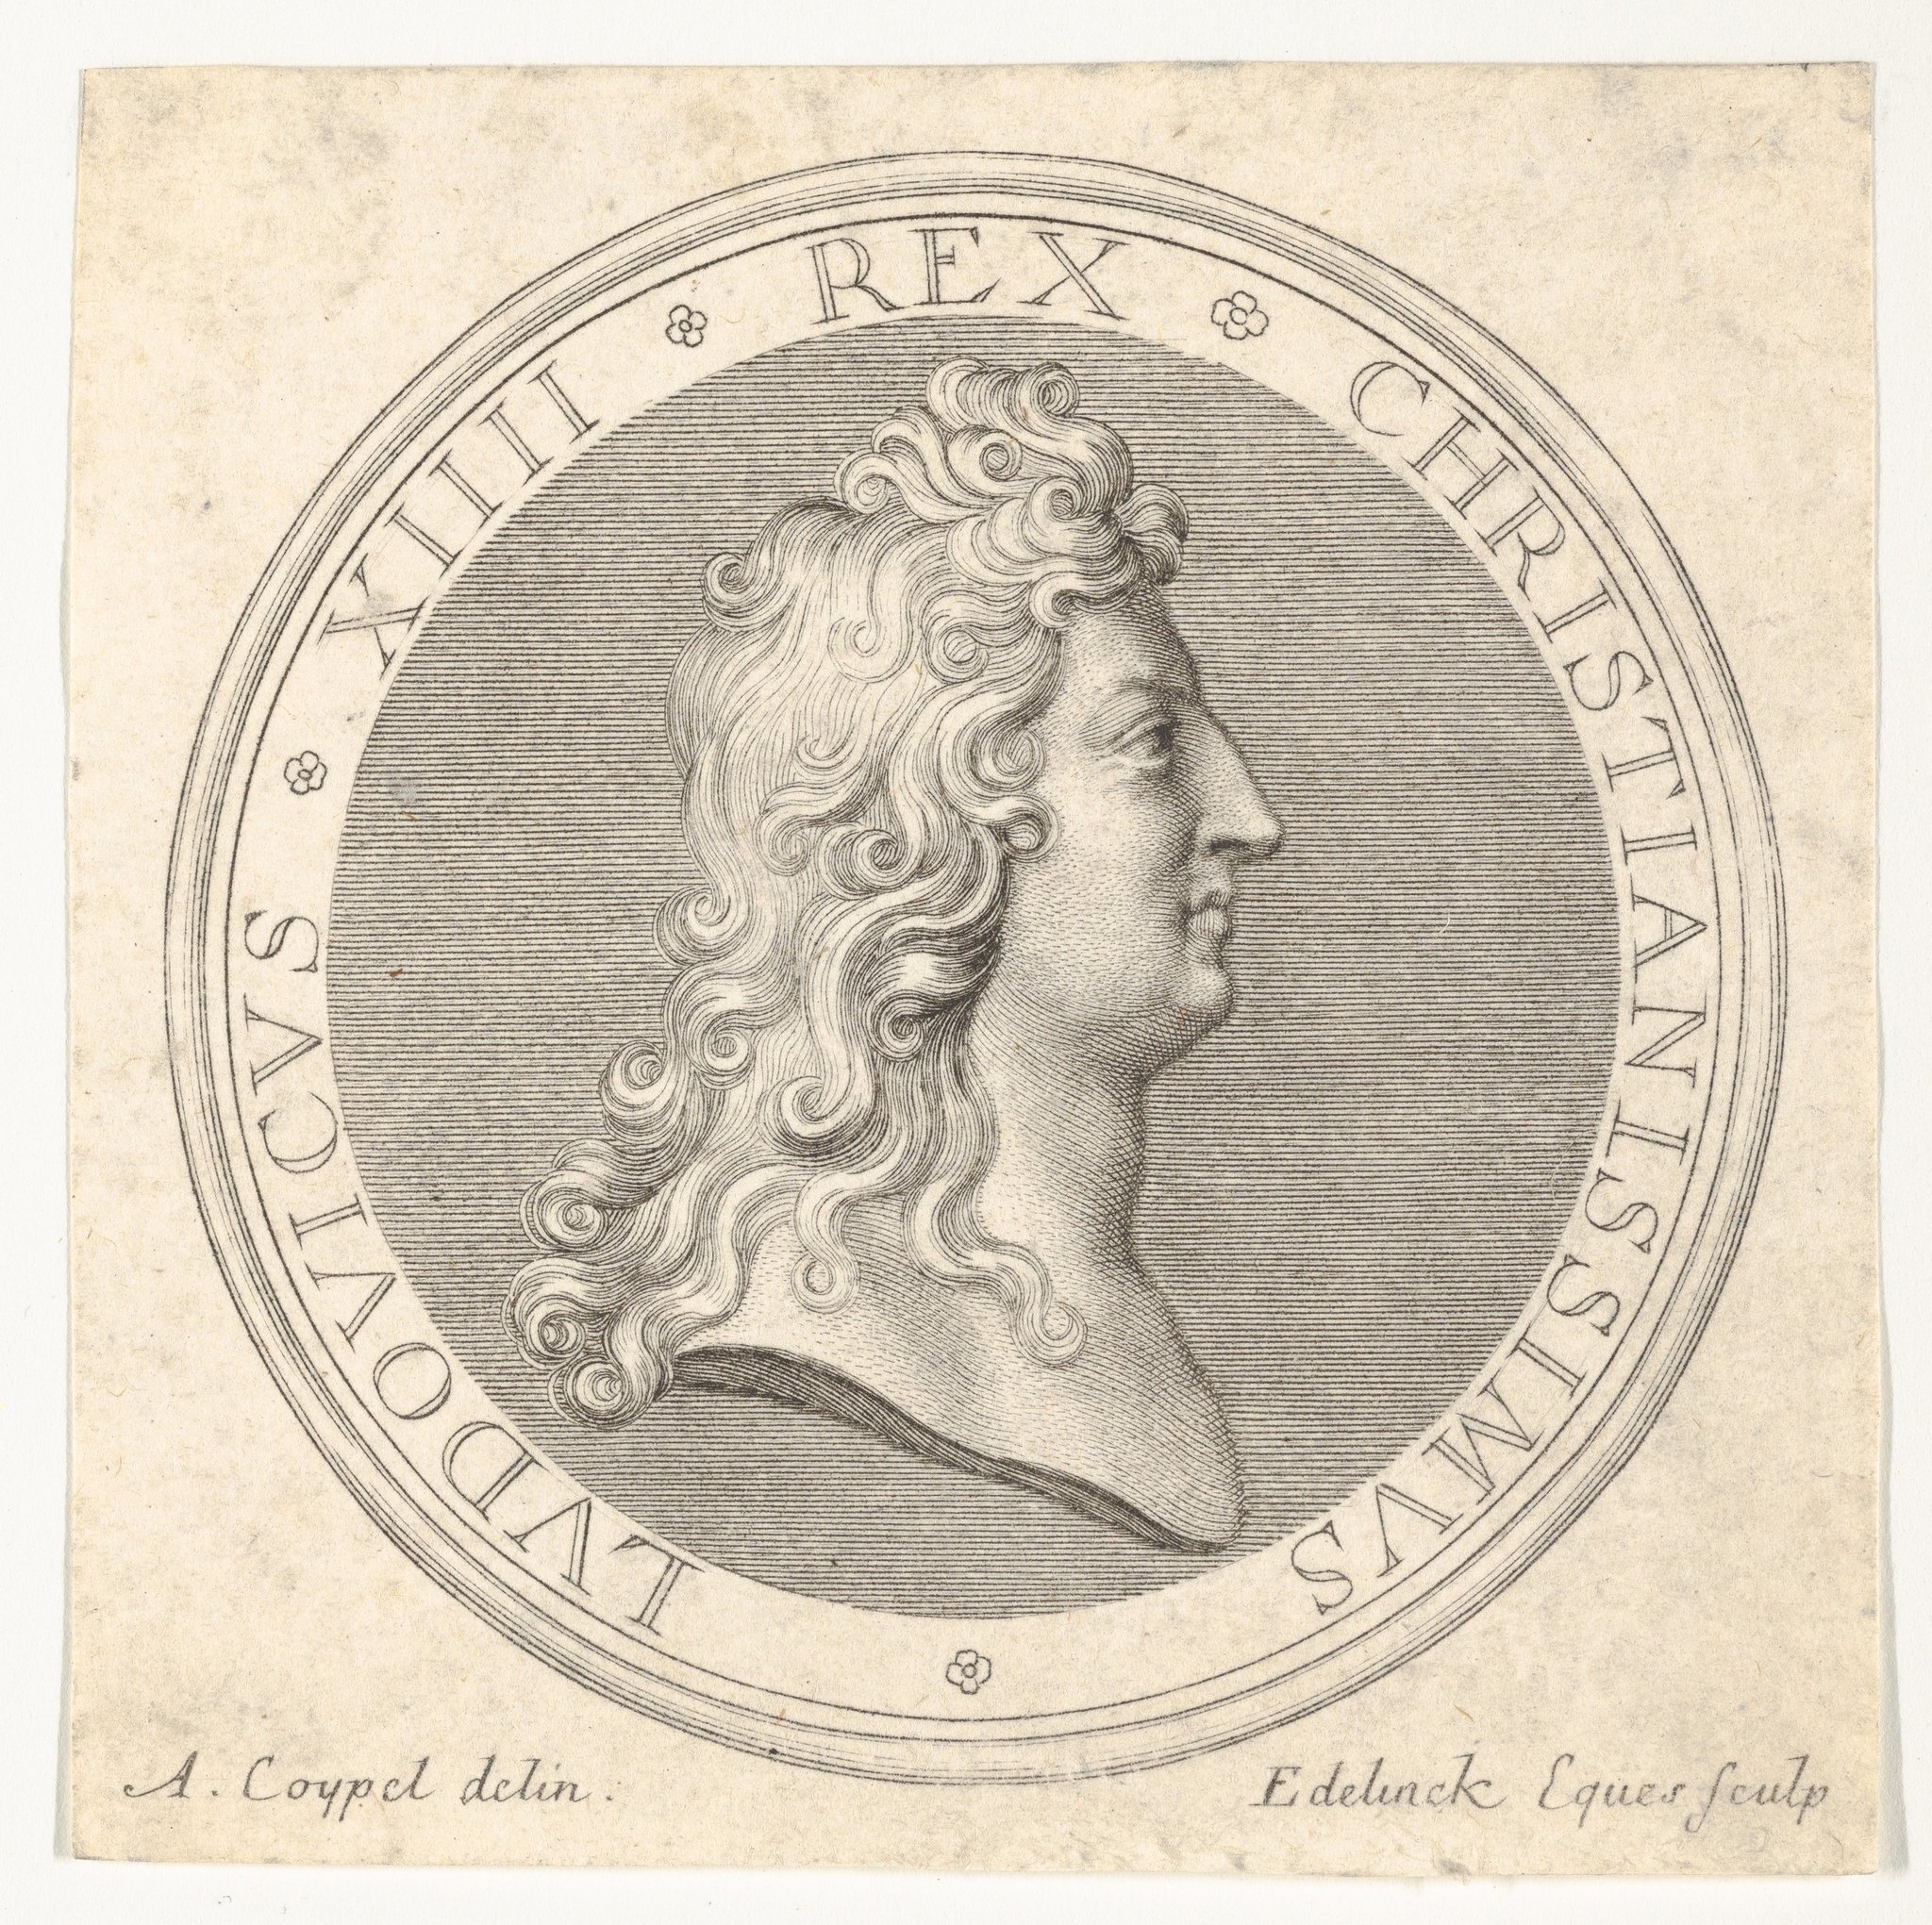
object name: print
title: Medal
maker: gerard edelinck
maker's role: artist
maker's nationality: dutch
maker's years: 1640-1707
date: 1601-1800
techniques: engraving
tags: men,profiles